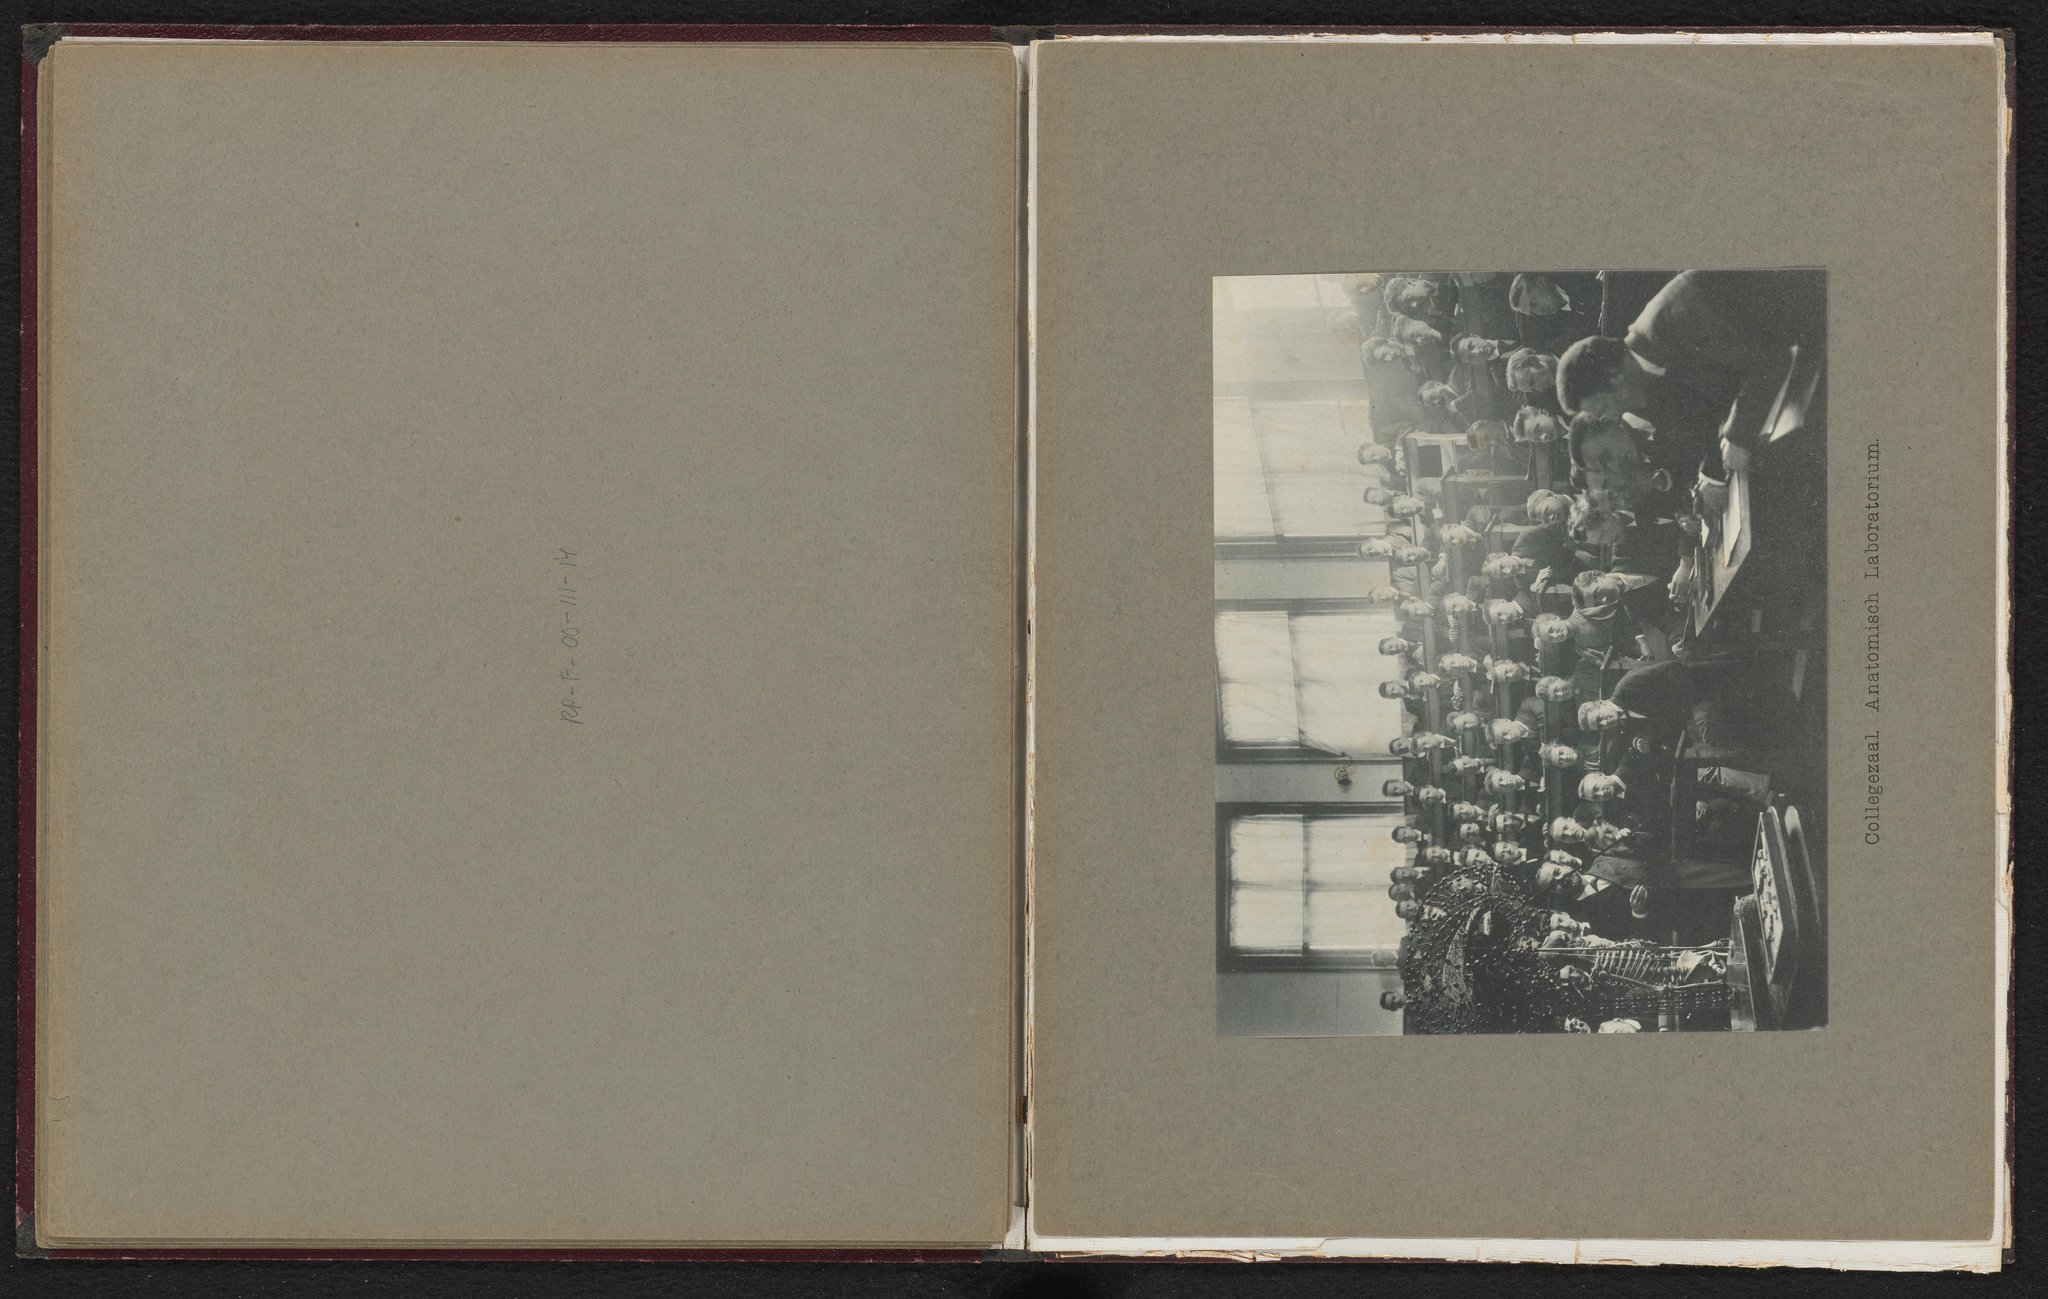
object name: photomechanical print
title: Collegezaal. Anatomisch Laboratorium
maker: Anonymous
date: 1902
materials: cardboard, paper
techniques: photograph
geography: amsterdam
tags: university building, college, anatomy lesson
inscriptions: stamp: ‘HISTORISCHE COMMISSIE DER UNIVERSITEIT VAN AMSTERDAM’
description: Deze prent maakt deel uit van een omslag met vijftien lichtdrukken op twaalf kartonnen bladen.